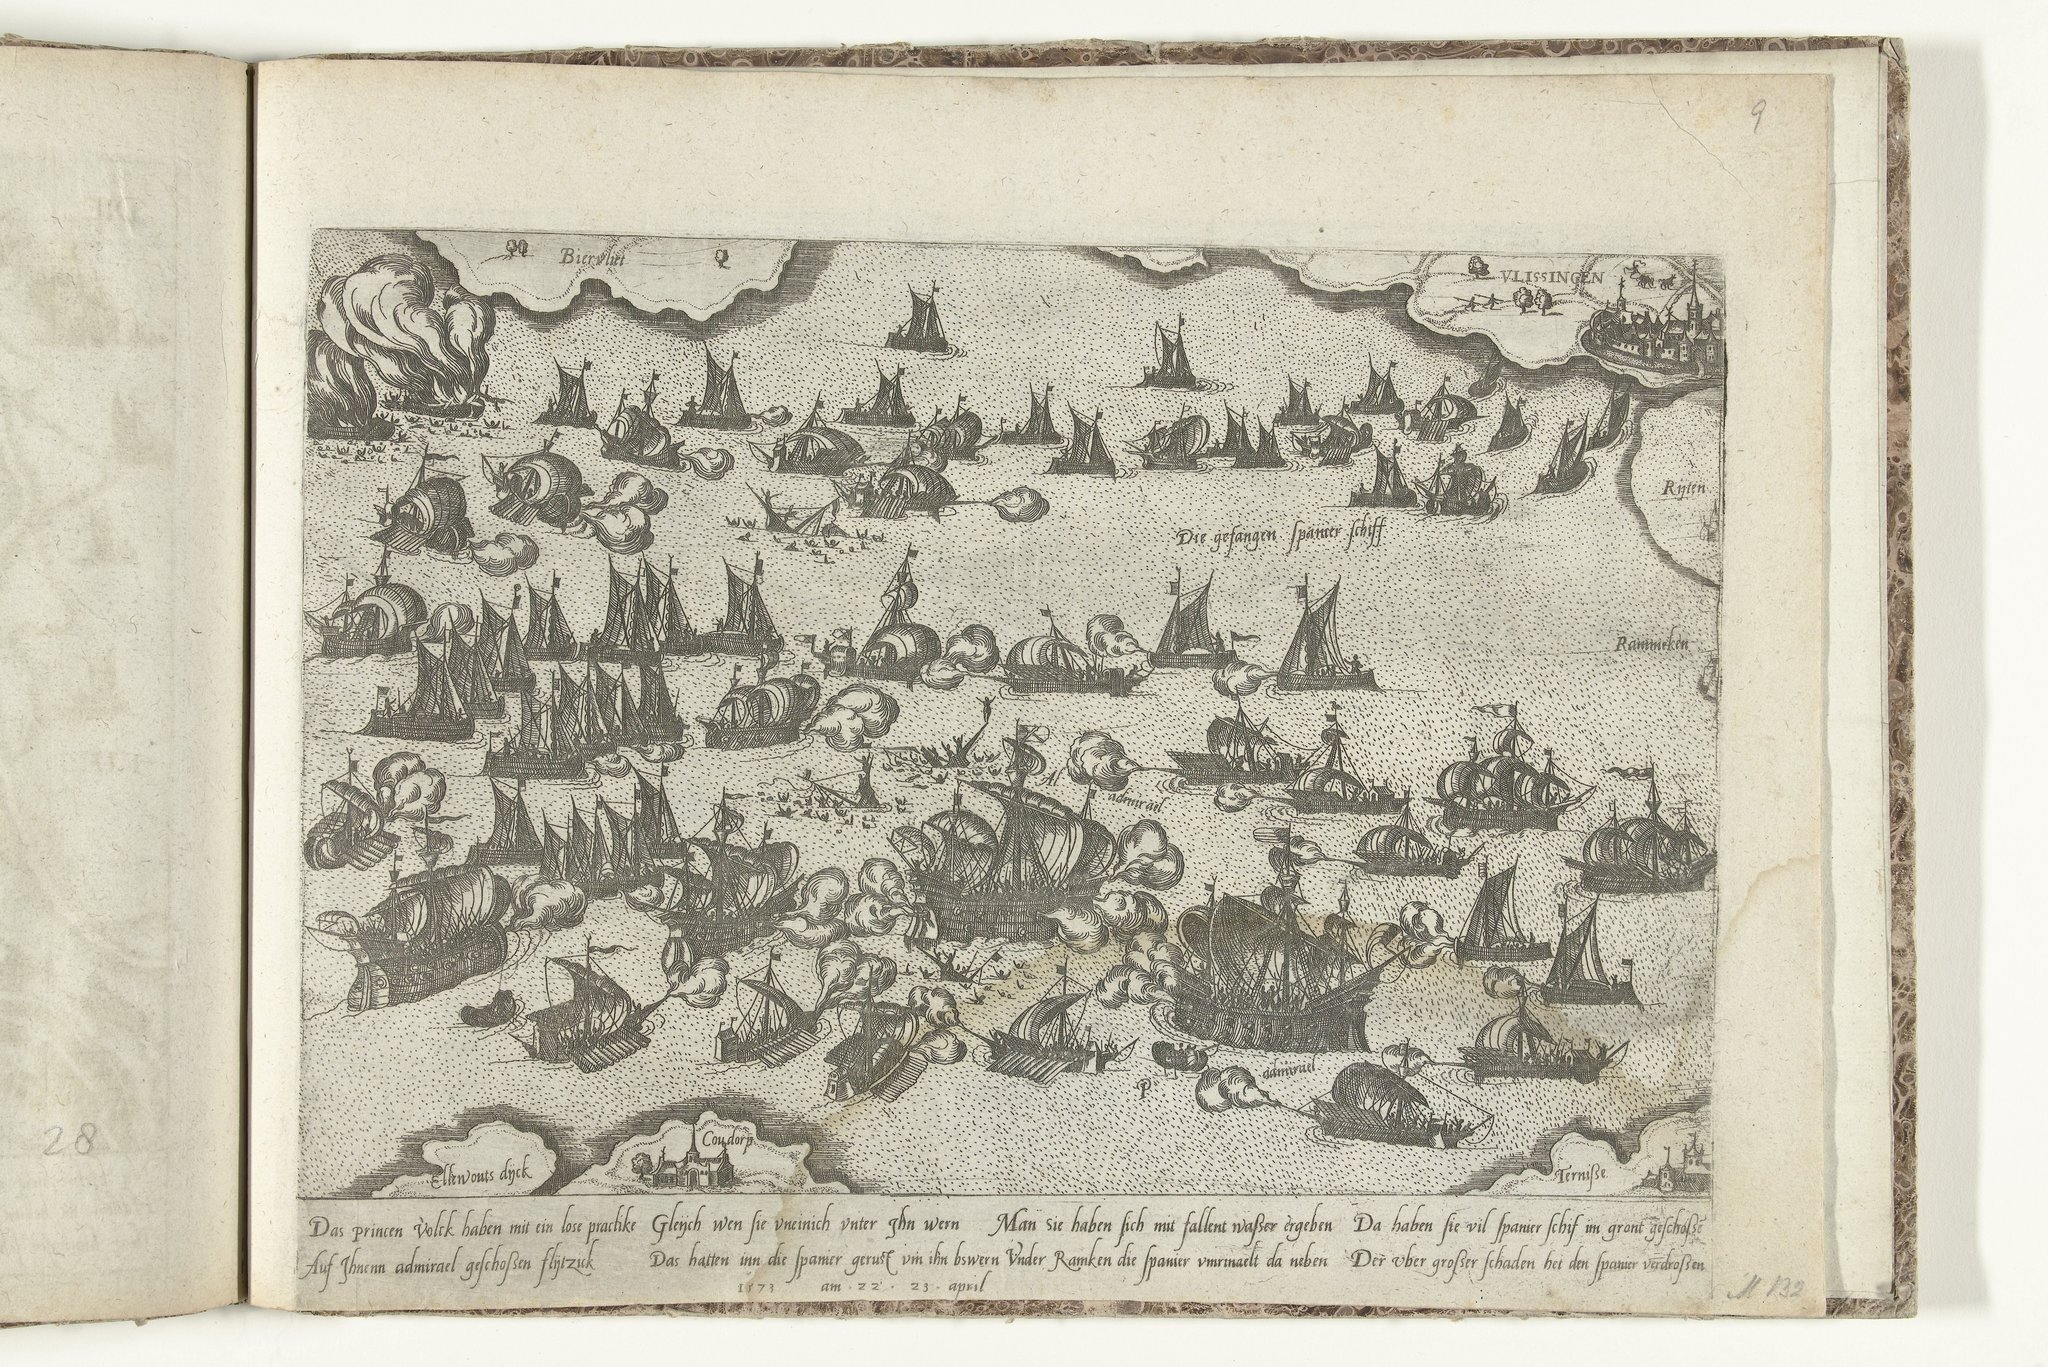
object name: print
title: Overwinning op de Spaanse vloot bij Vlissingen, 1573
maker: Anonymous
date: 1573-1575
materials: paper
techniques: etching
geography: germany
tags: battle (+ naval force), flushing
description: Overwinning op de Spaanse vloot bij Vlissingen, 22 -23 april 1573. De Spaanse schepen die Middelburg wilden ontzetten worden door de watergeuzen verslagen op de Schelde bij Vlissingen. Met onderschrift van 2 regels in het Duits en de datum. Ongenummerd. De prent maakt deel uit van een album.